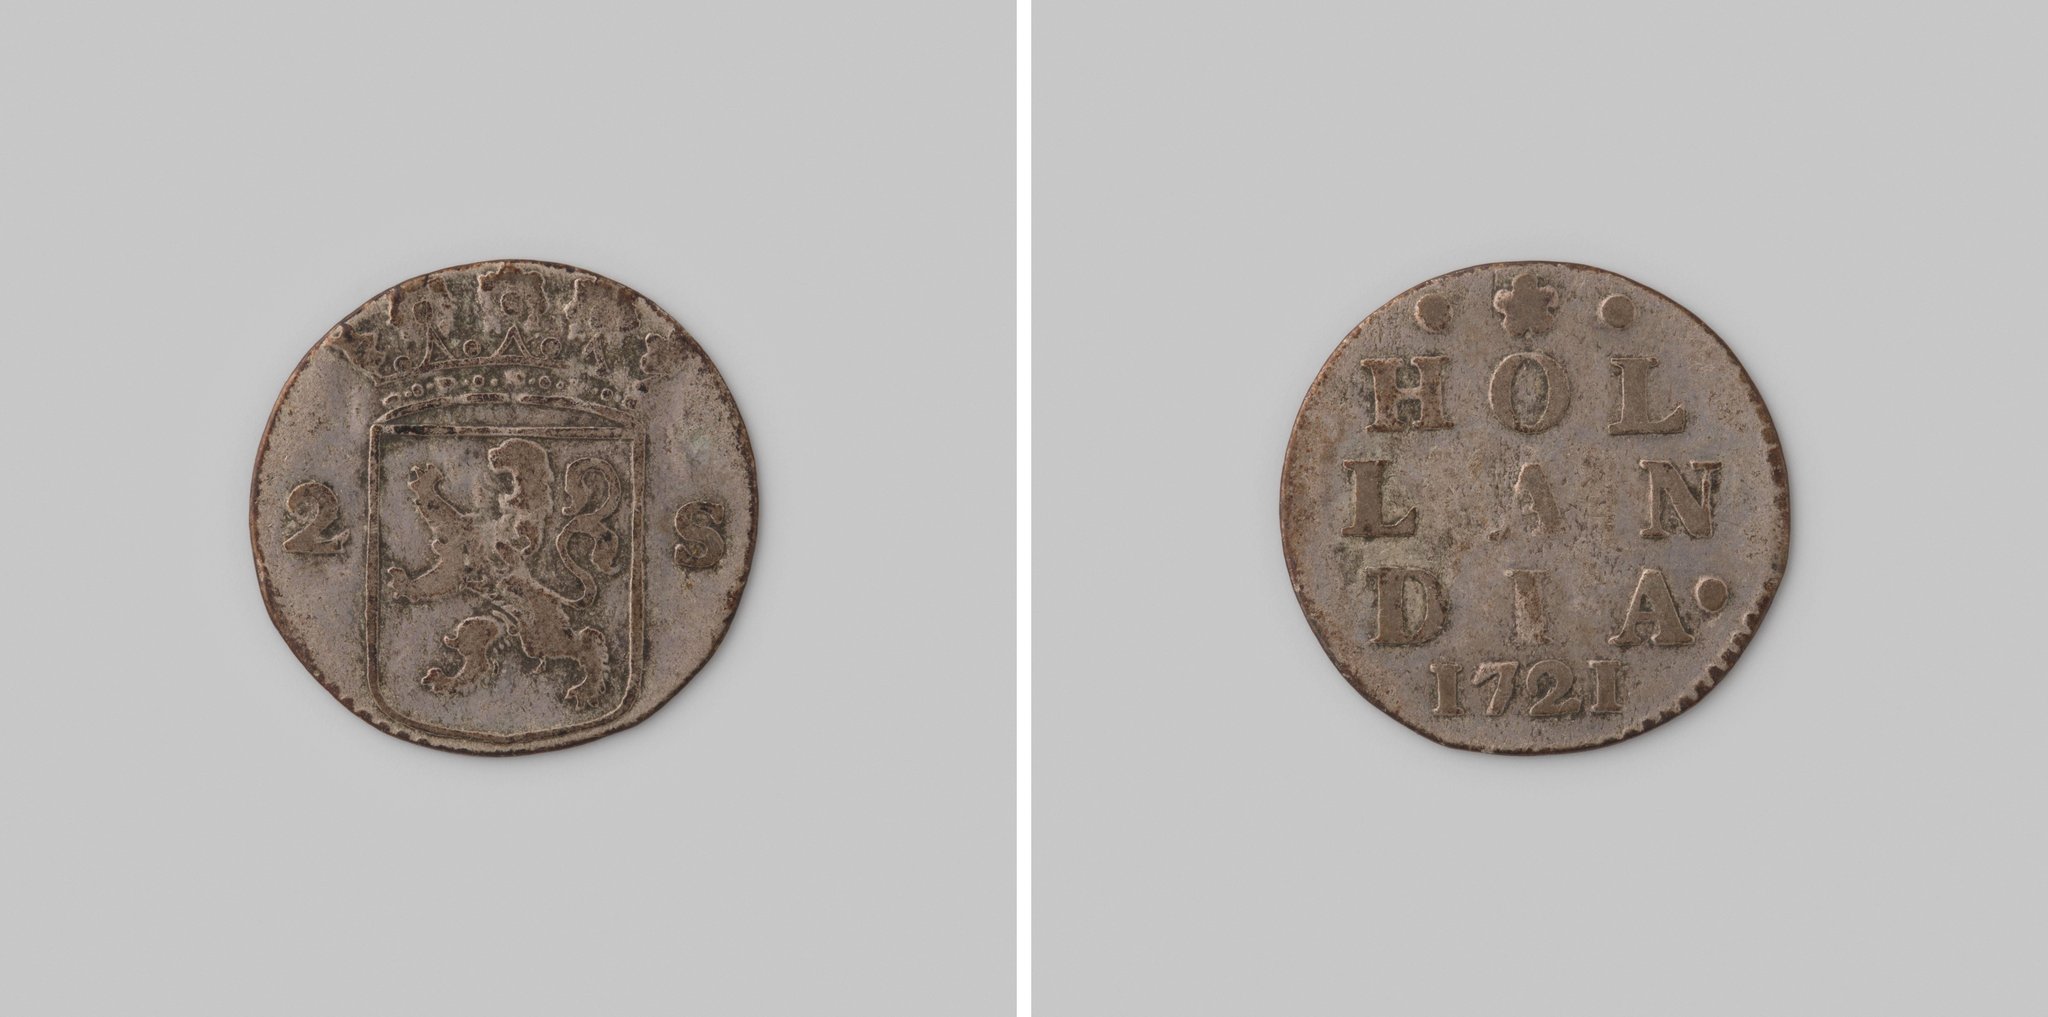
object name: coin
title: Hollandse dubbele stuiver, 1721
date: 1721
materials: silver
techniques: striking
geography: dordrecht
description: Zilveren munt. Voorzijde: tussen waarde-aanduiding 2 S gekroond wapenschild van Holland. Keerzijde: opschrift: provincienaam in drie regels, daaronder jaartal.